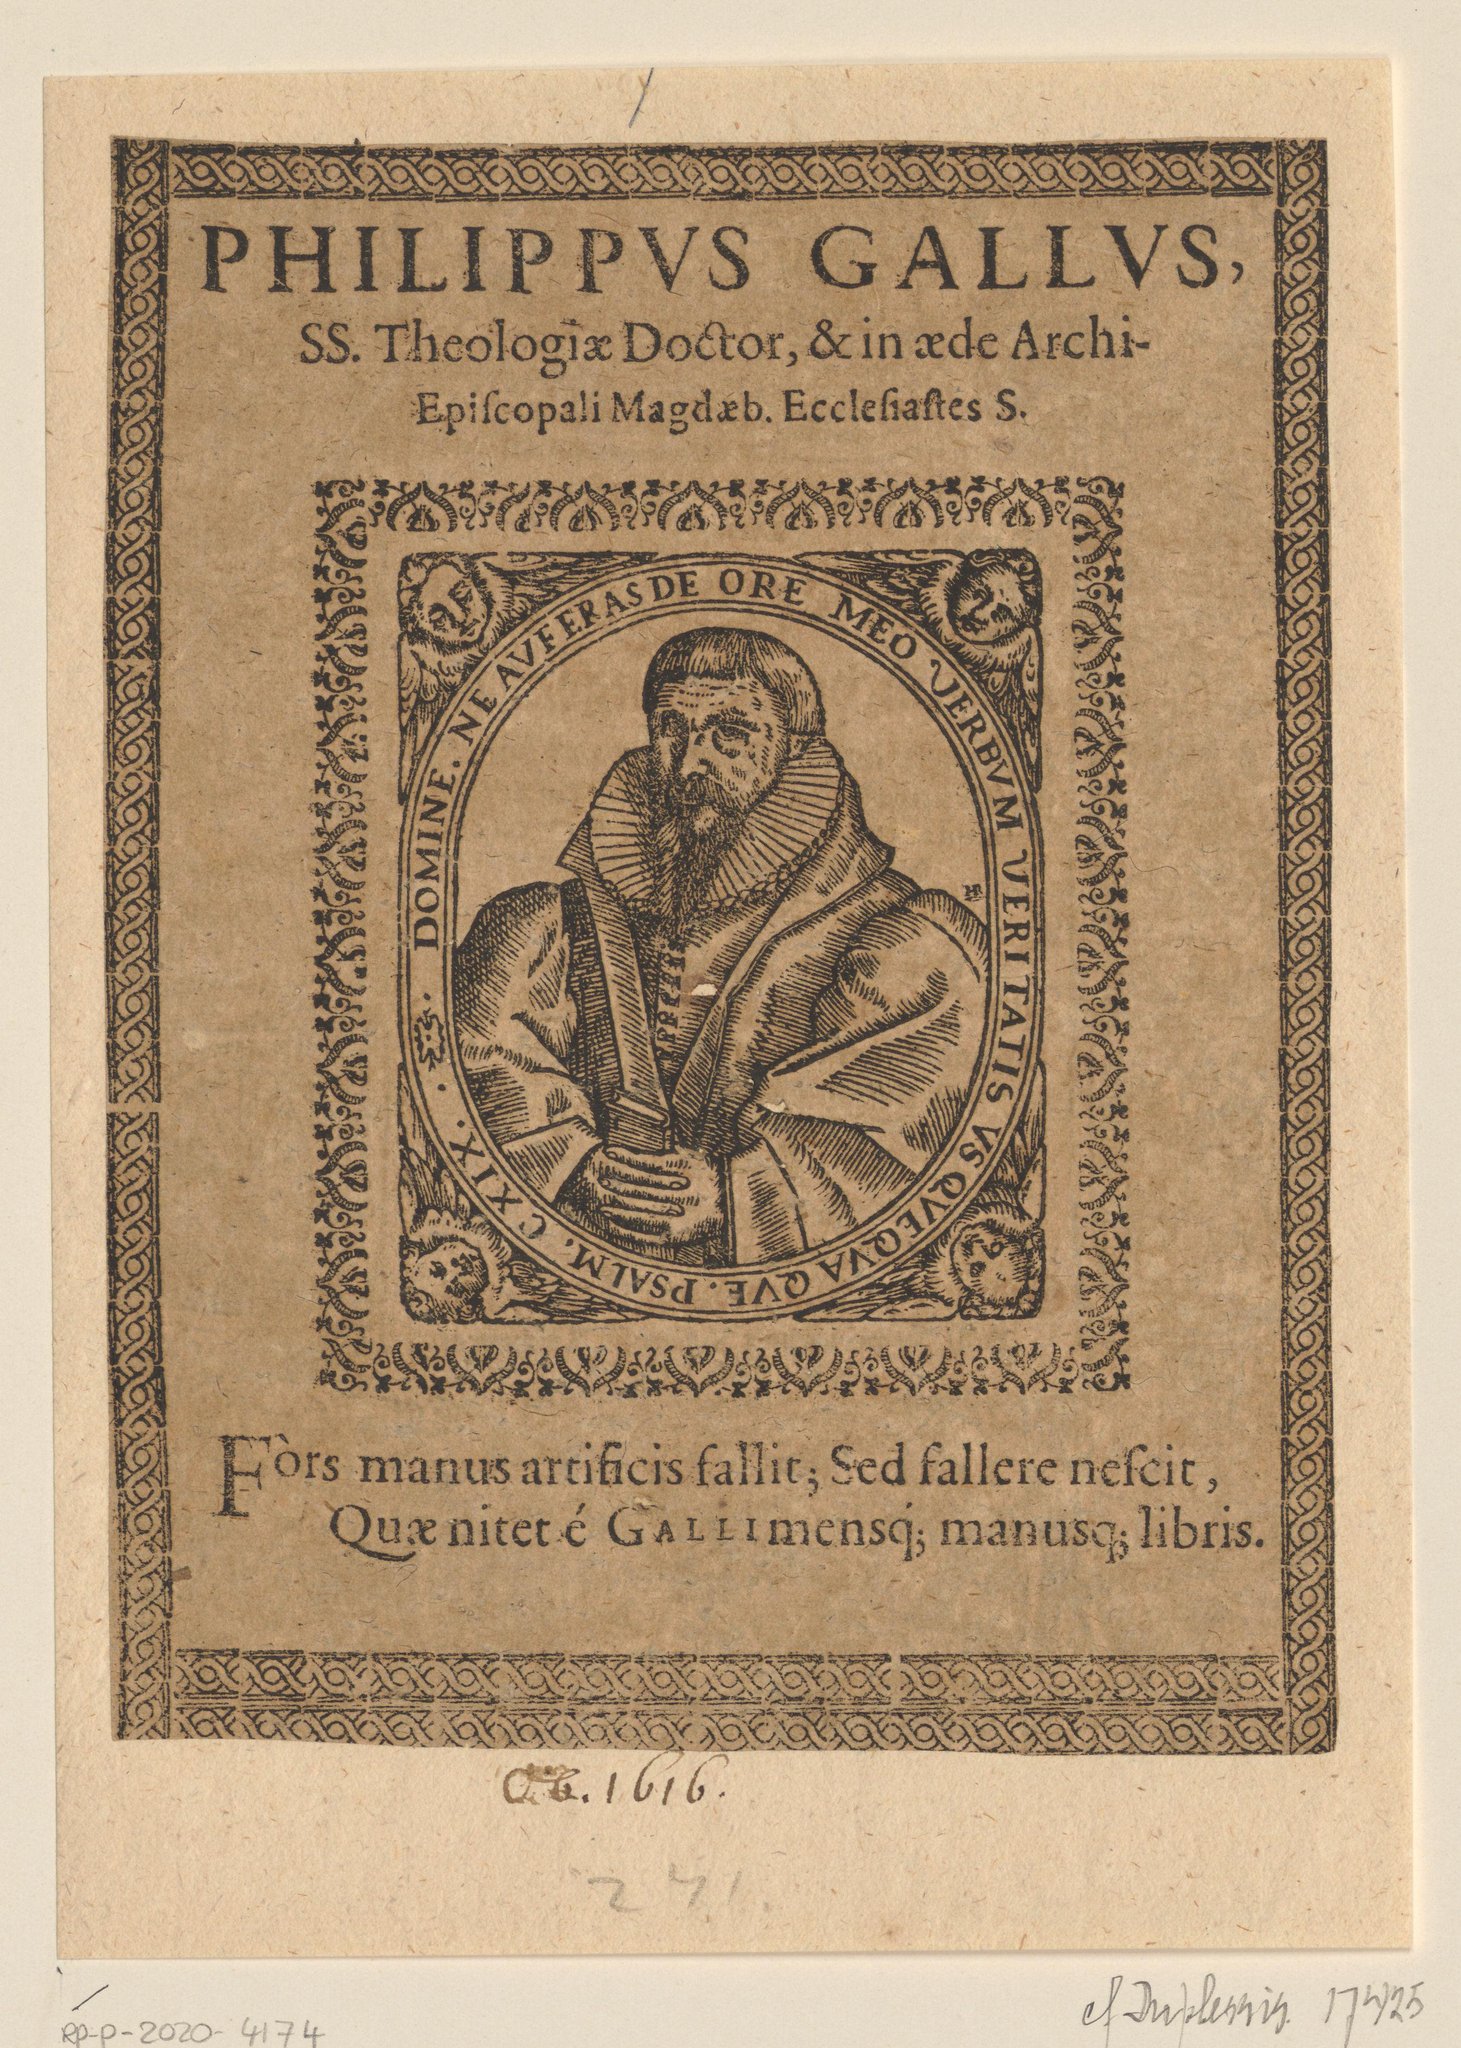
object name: print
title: Portret van Philipp Hahn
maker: Anonymous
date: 1688-1690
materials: paper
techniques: letterpress printing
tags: theologian, historical persons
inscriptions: inscription: ‘o.b. 1616’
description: Andere staat van prent gebruikt in: Zeidler, Johann Gottfried. Theatri eruditorum pictura, carmine historia elaborandi compendium Centum Imagunculas doctissimorum Virorum. Wittenberg: Henckel, Matthäus, 1690.